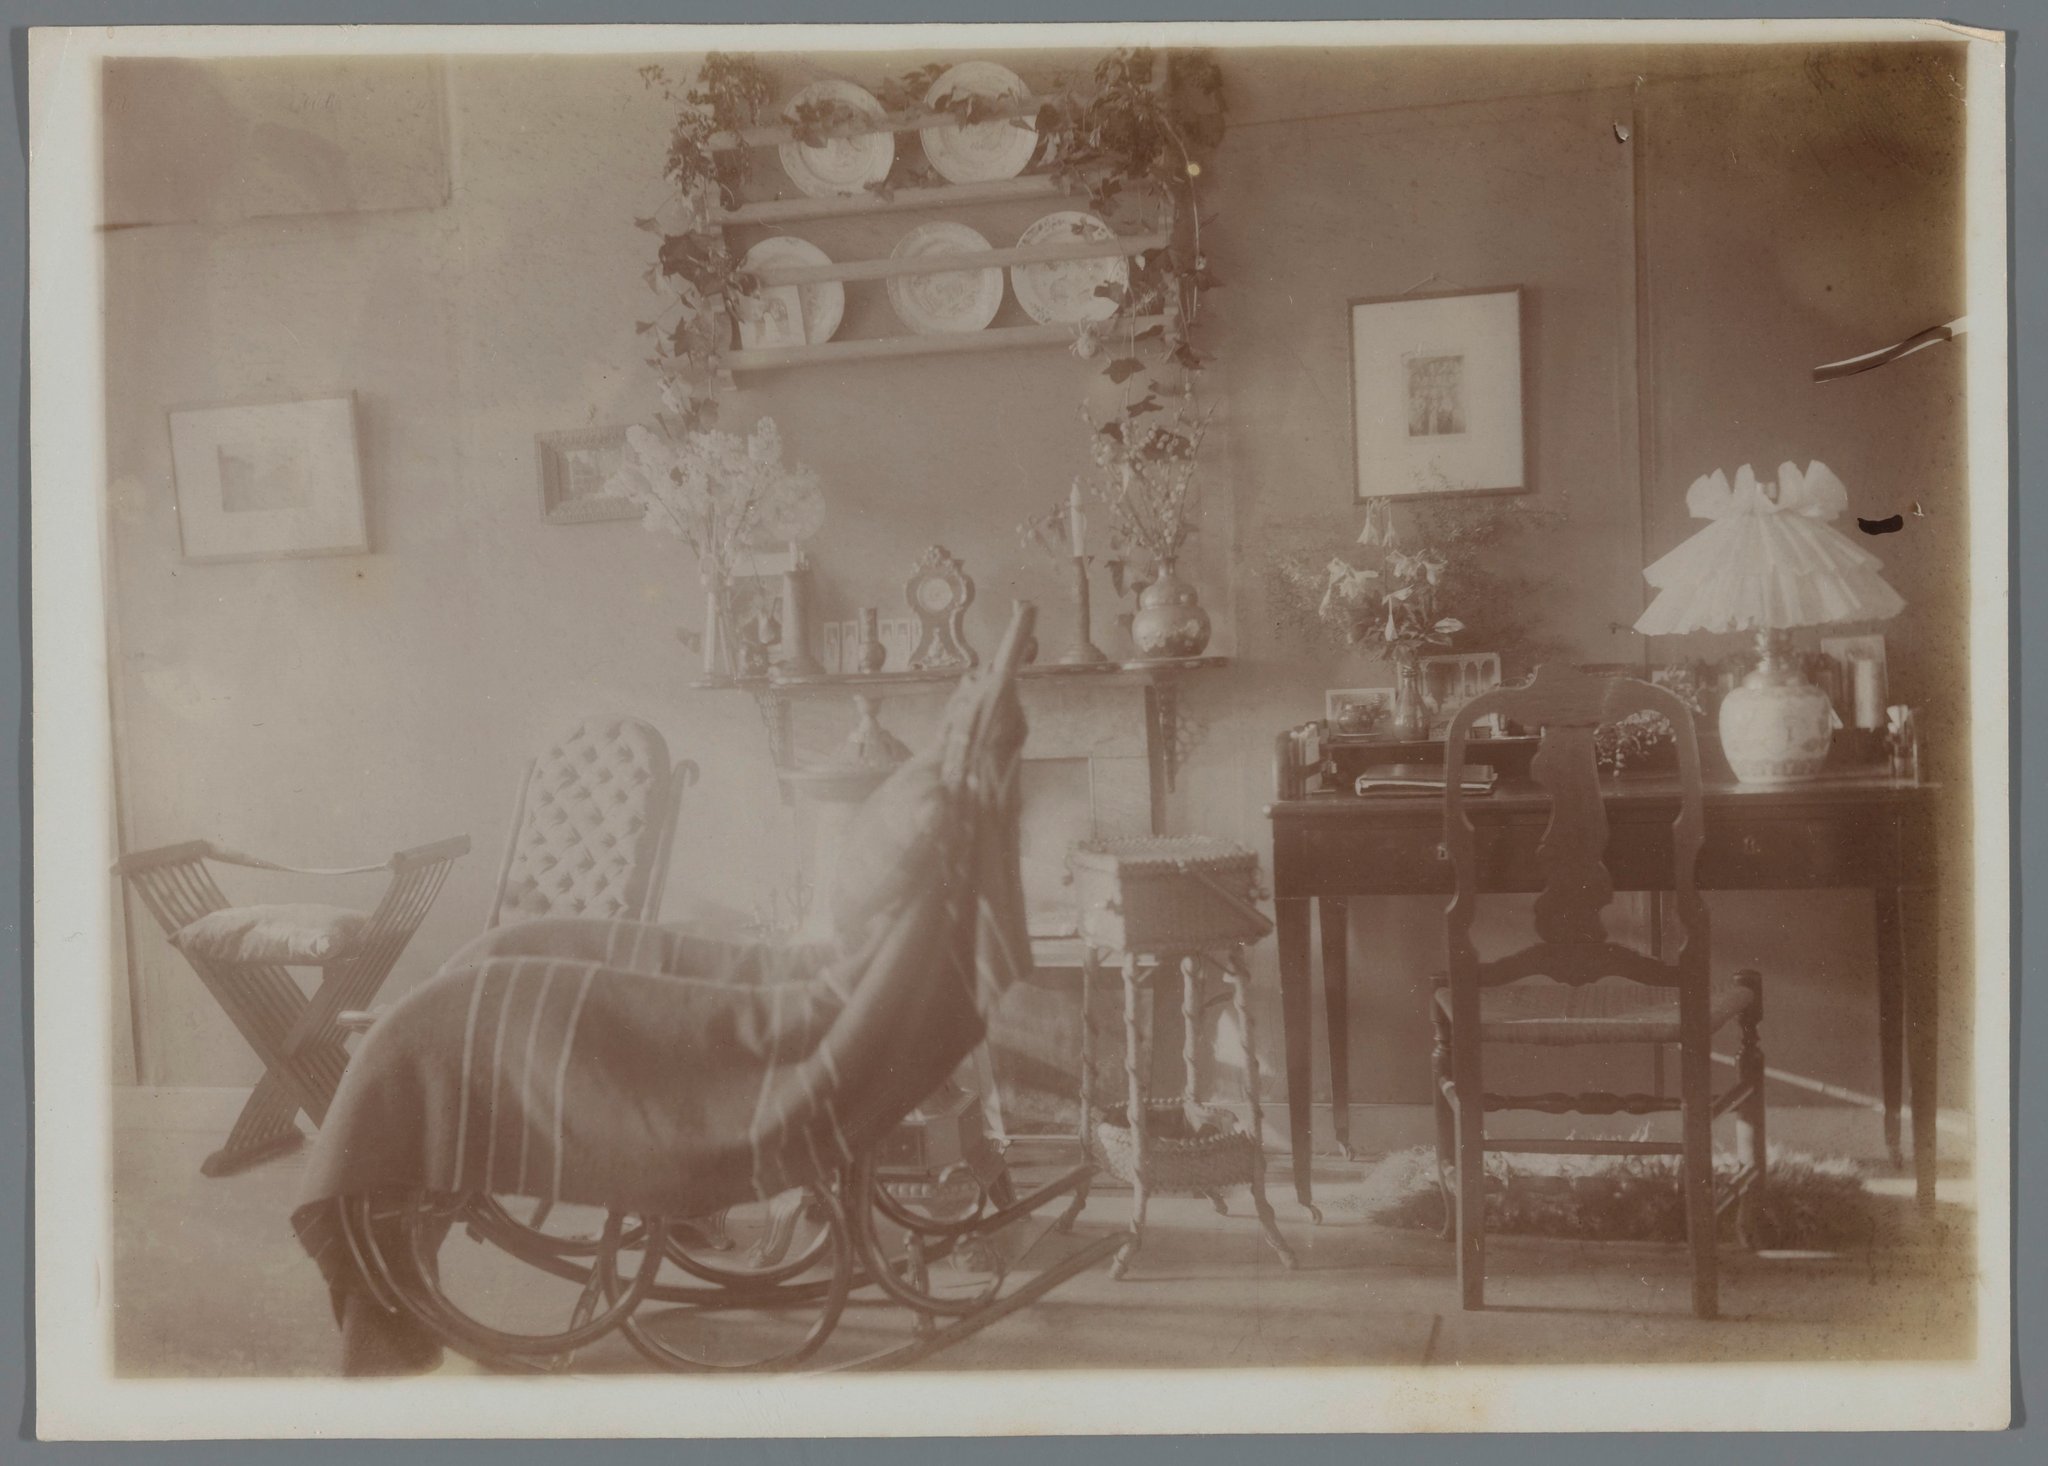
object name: photograph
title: Interieur van een kamer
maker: cornelia hendrika jonker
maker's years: 1874-1924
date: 1880-1920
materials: photographic support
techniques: collodion silver print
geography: maartensdijk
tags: rocking-chair, interior of the house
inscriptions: annotation: ‘kamers Cor en Jen/ Rustenhoven’